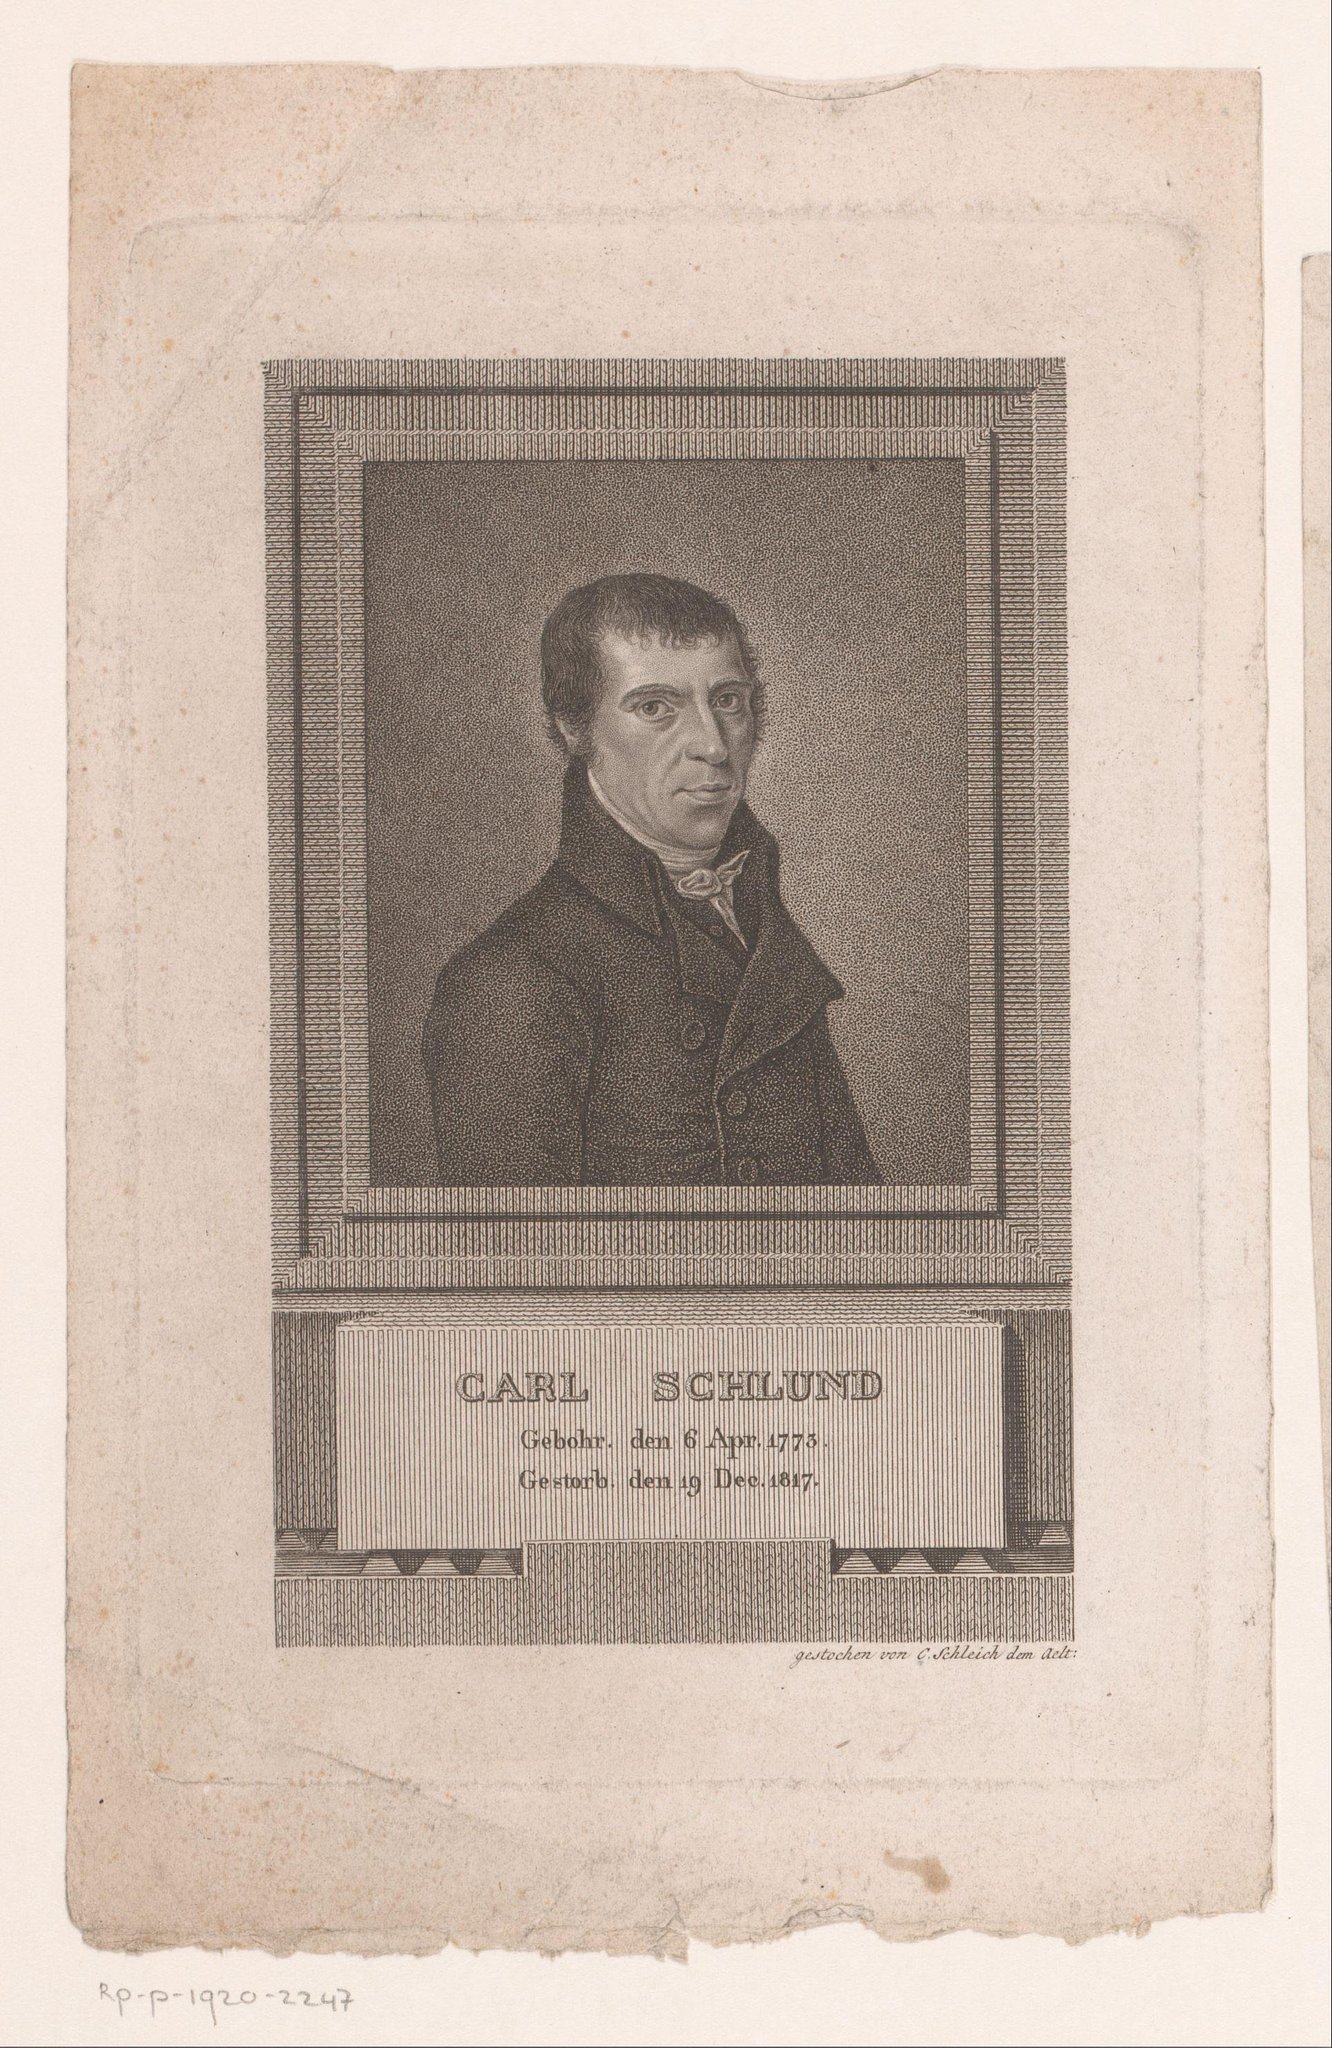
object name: print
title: Portret van Carl Schlund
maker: johann carl schleich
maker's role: print maker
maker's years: 1759-1842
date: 1769-1842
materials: paper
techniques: engraving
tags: theologian, historical persons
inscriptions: collector's mark: Lugt 2228